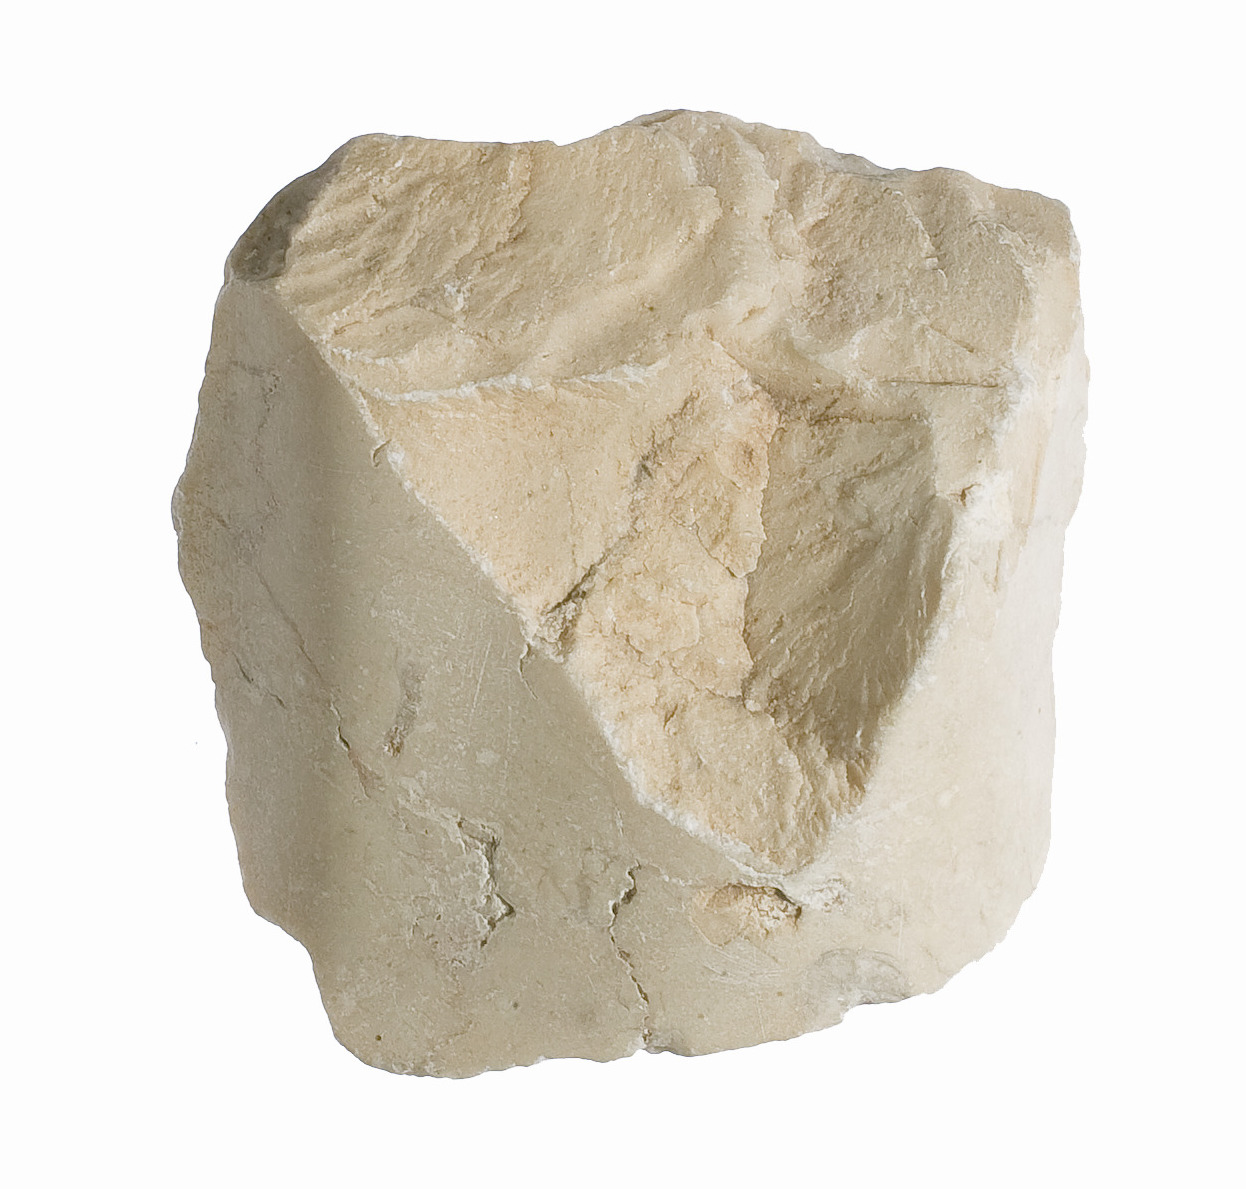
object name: arm at wrist, leg at knee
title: Arm at wrist, leg at knee (?)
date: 1353-1336 BCE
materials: limestone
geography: egypt